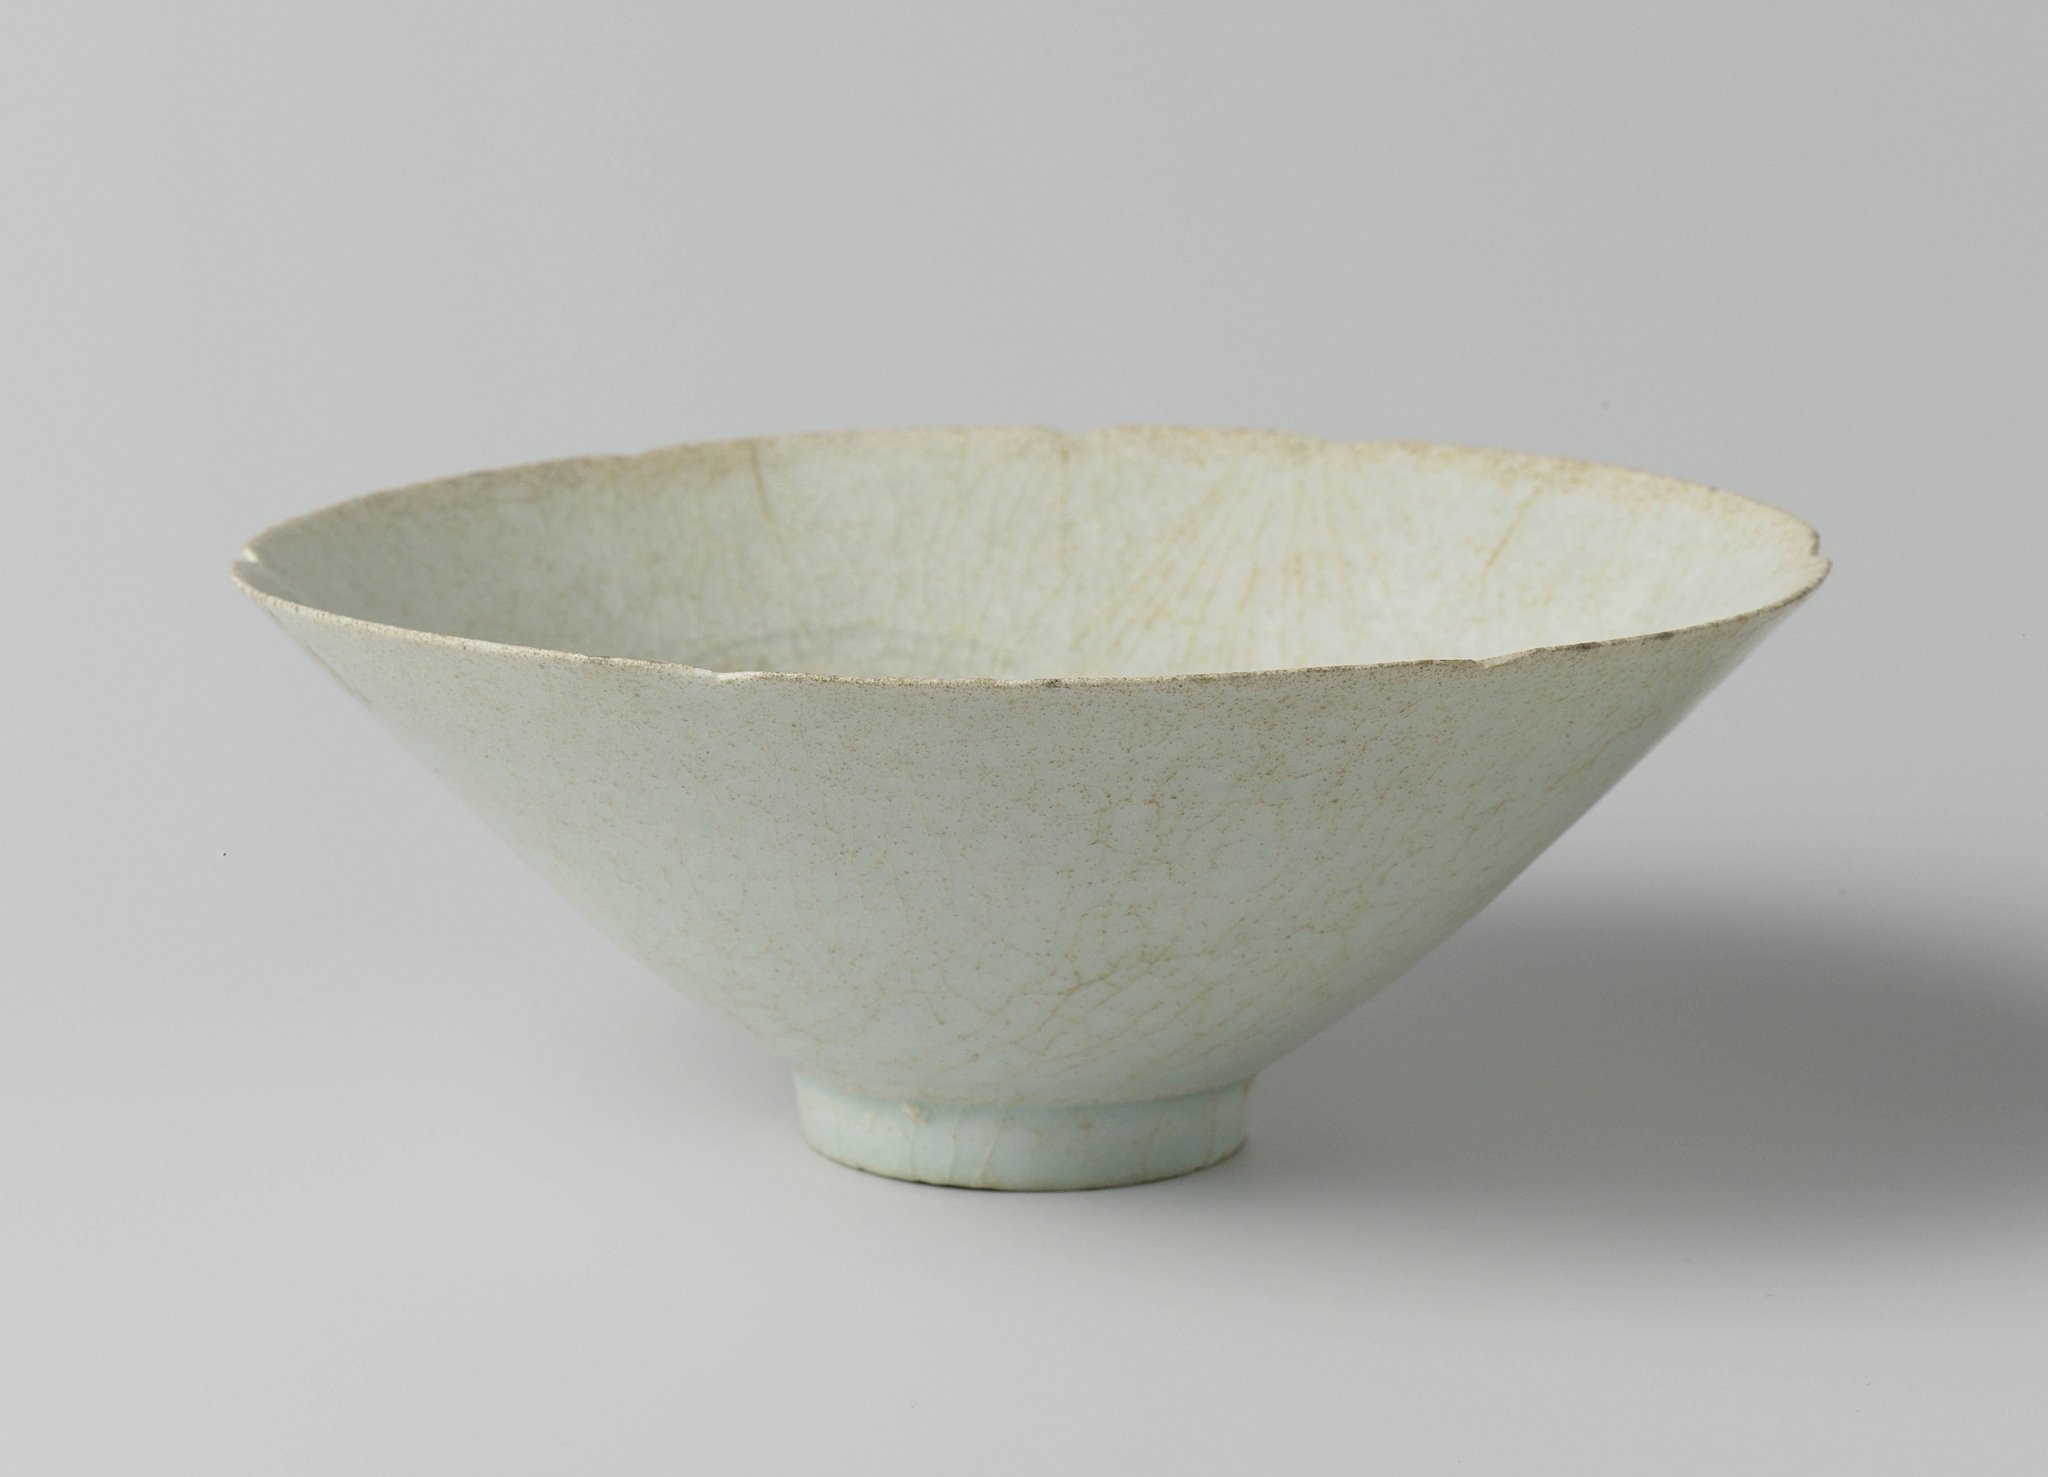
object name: bowl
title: Conical bowl with three incised medallions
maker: Anonymous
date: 960-1279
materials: glaze, stoneware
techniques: engraving, firing, turning, vitrification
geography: china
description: Conische kom van steengoed met een geschulpte rand, bedekt met een transparant glazuur met een lichtblauwe tint. Op de binnenwand driemaal een ingegrift medaillon met een decoratie. Twee barsten in de rand. Qingbai.